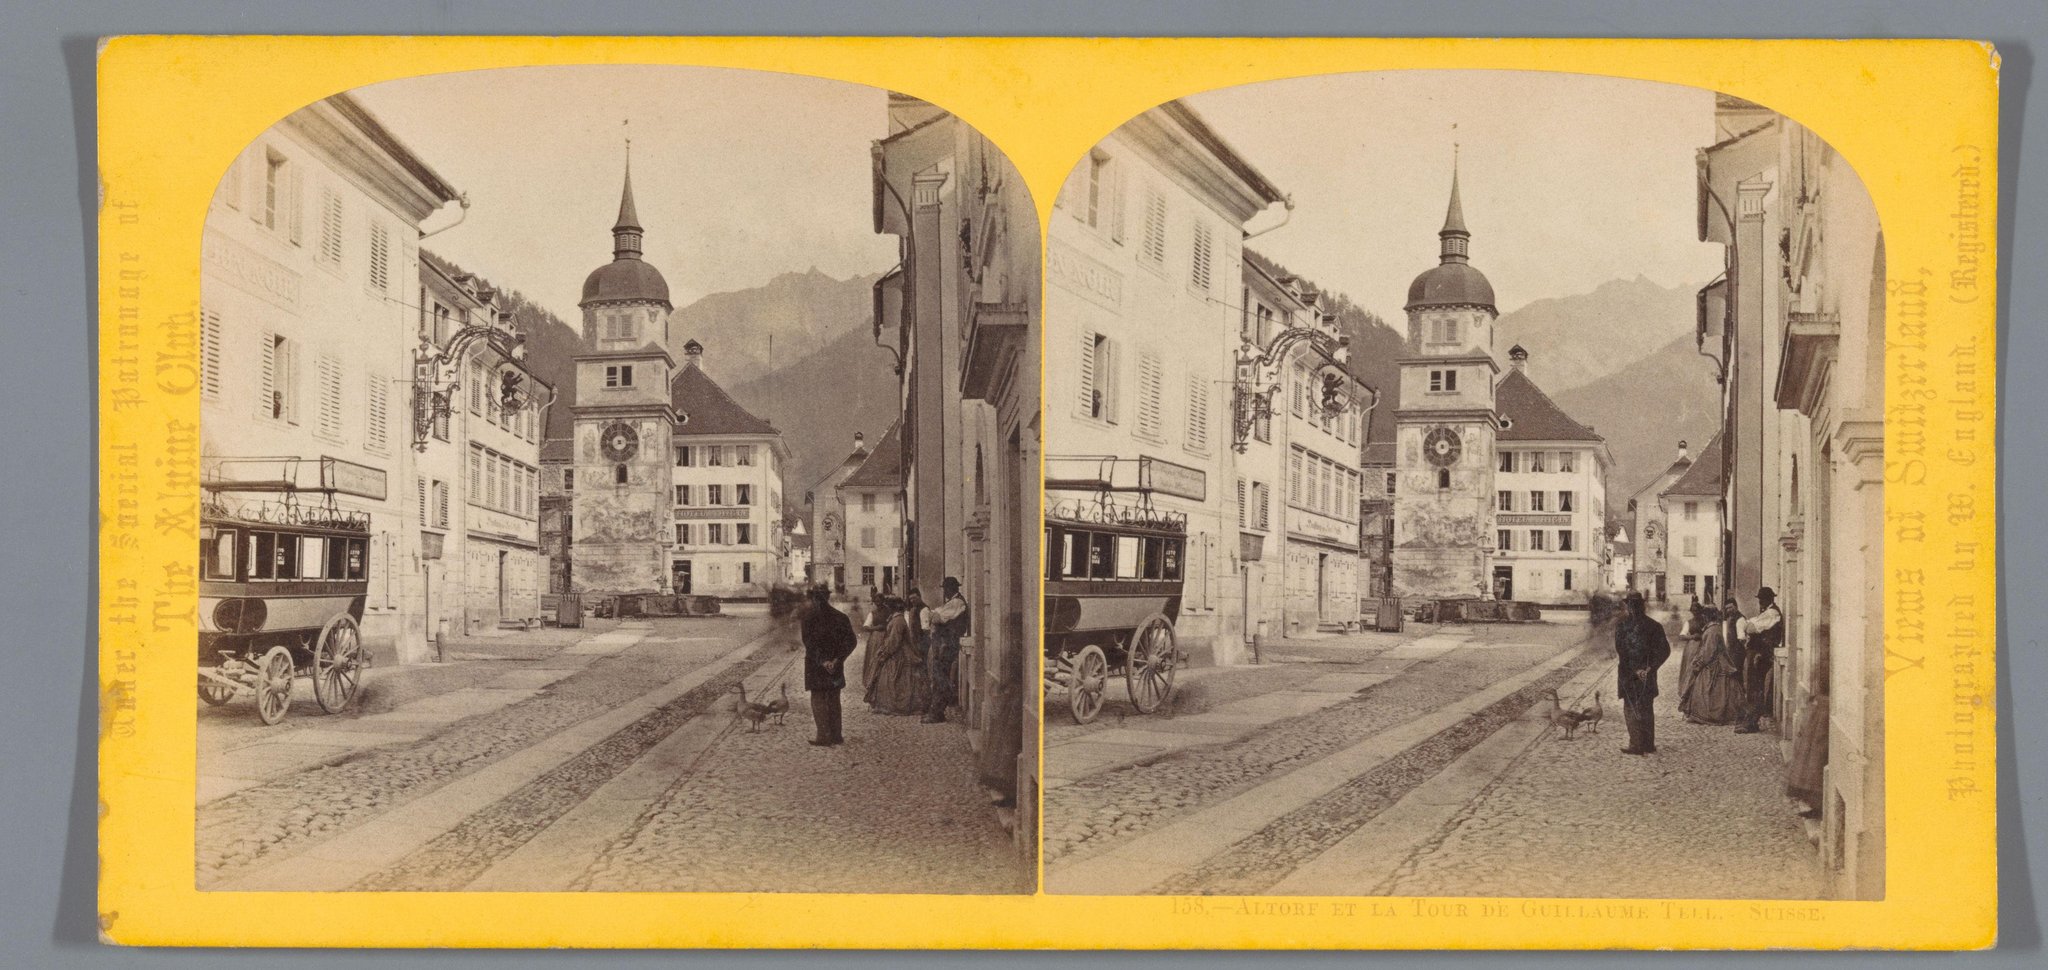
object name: stereograph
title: Altorf et la Tour de Guillaume Tell. Suisse.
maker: william england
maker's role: fotograaf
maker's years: 1816-1896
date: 1850-1880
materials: cardboard, photographic support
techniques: albumen print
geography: altdorf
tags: street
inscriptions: inscription: ‘Views of Switzerland, photographed by W. England. (Registered) Under the Special Patronage of the Alpine Club.’, number: ‘158.’